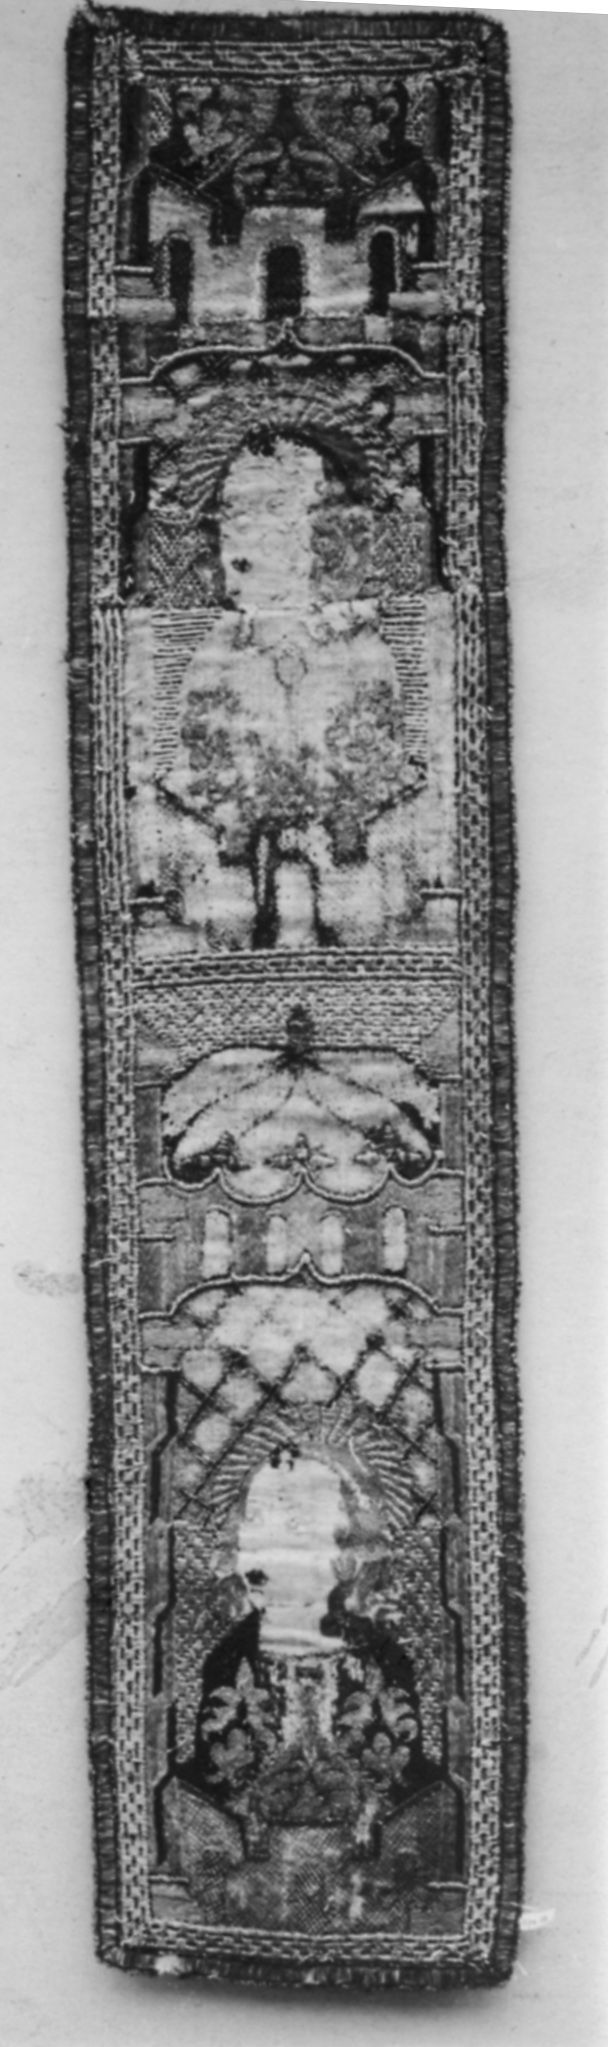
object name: orphrey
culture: spanish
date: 1501-1600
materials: gold thread, silk